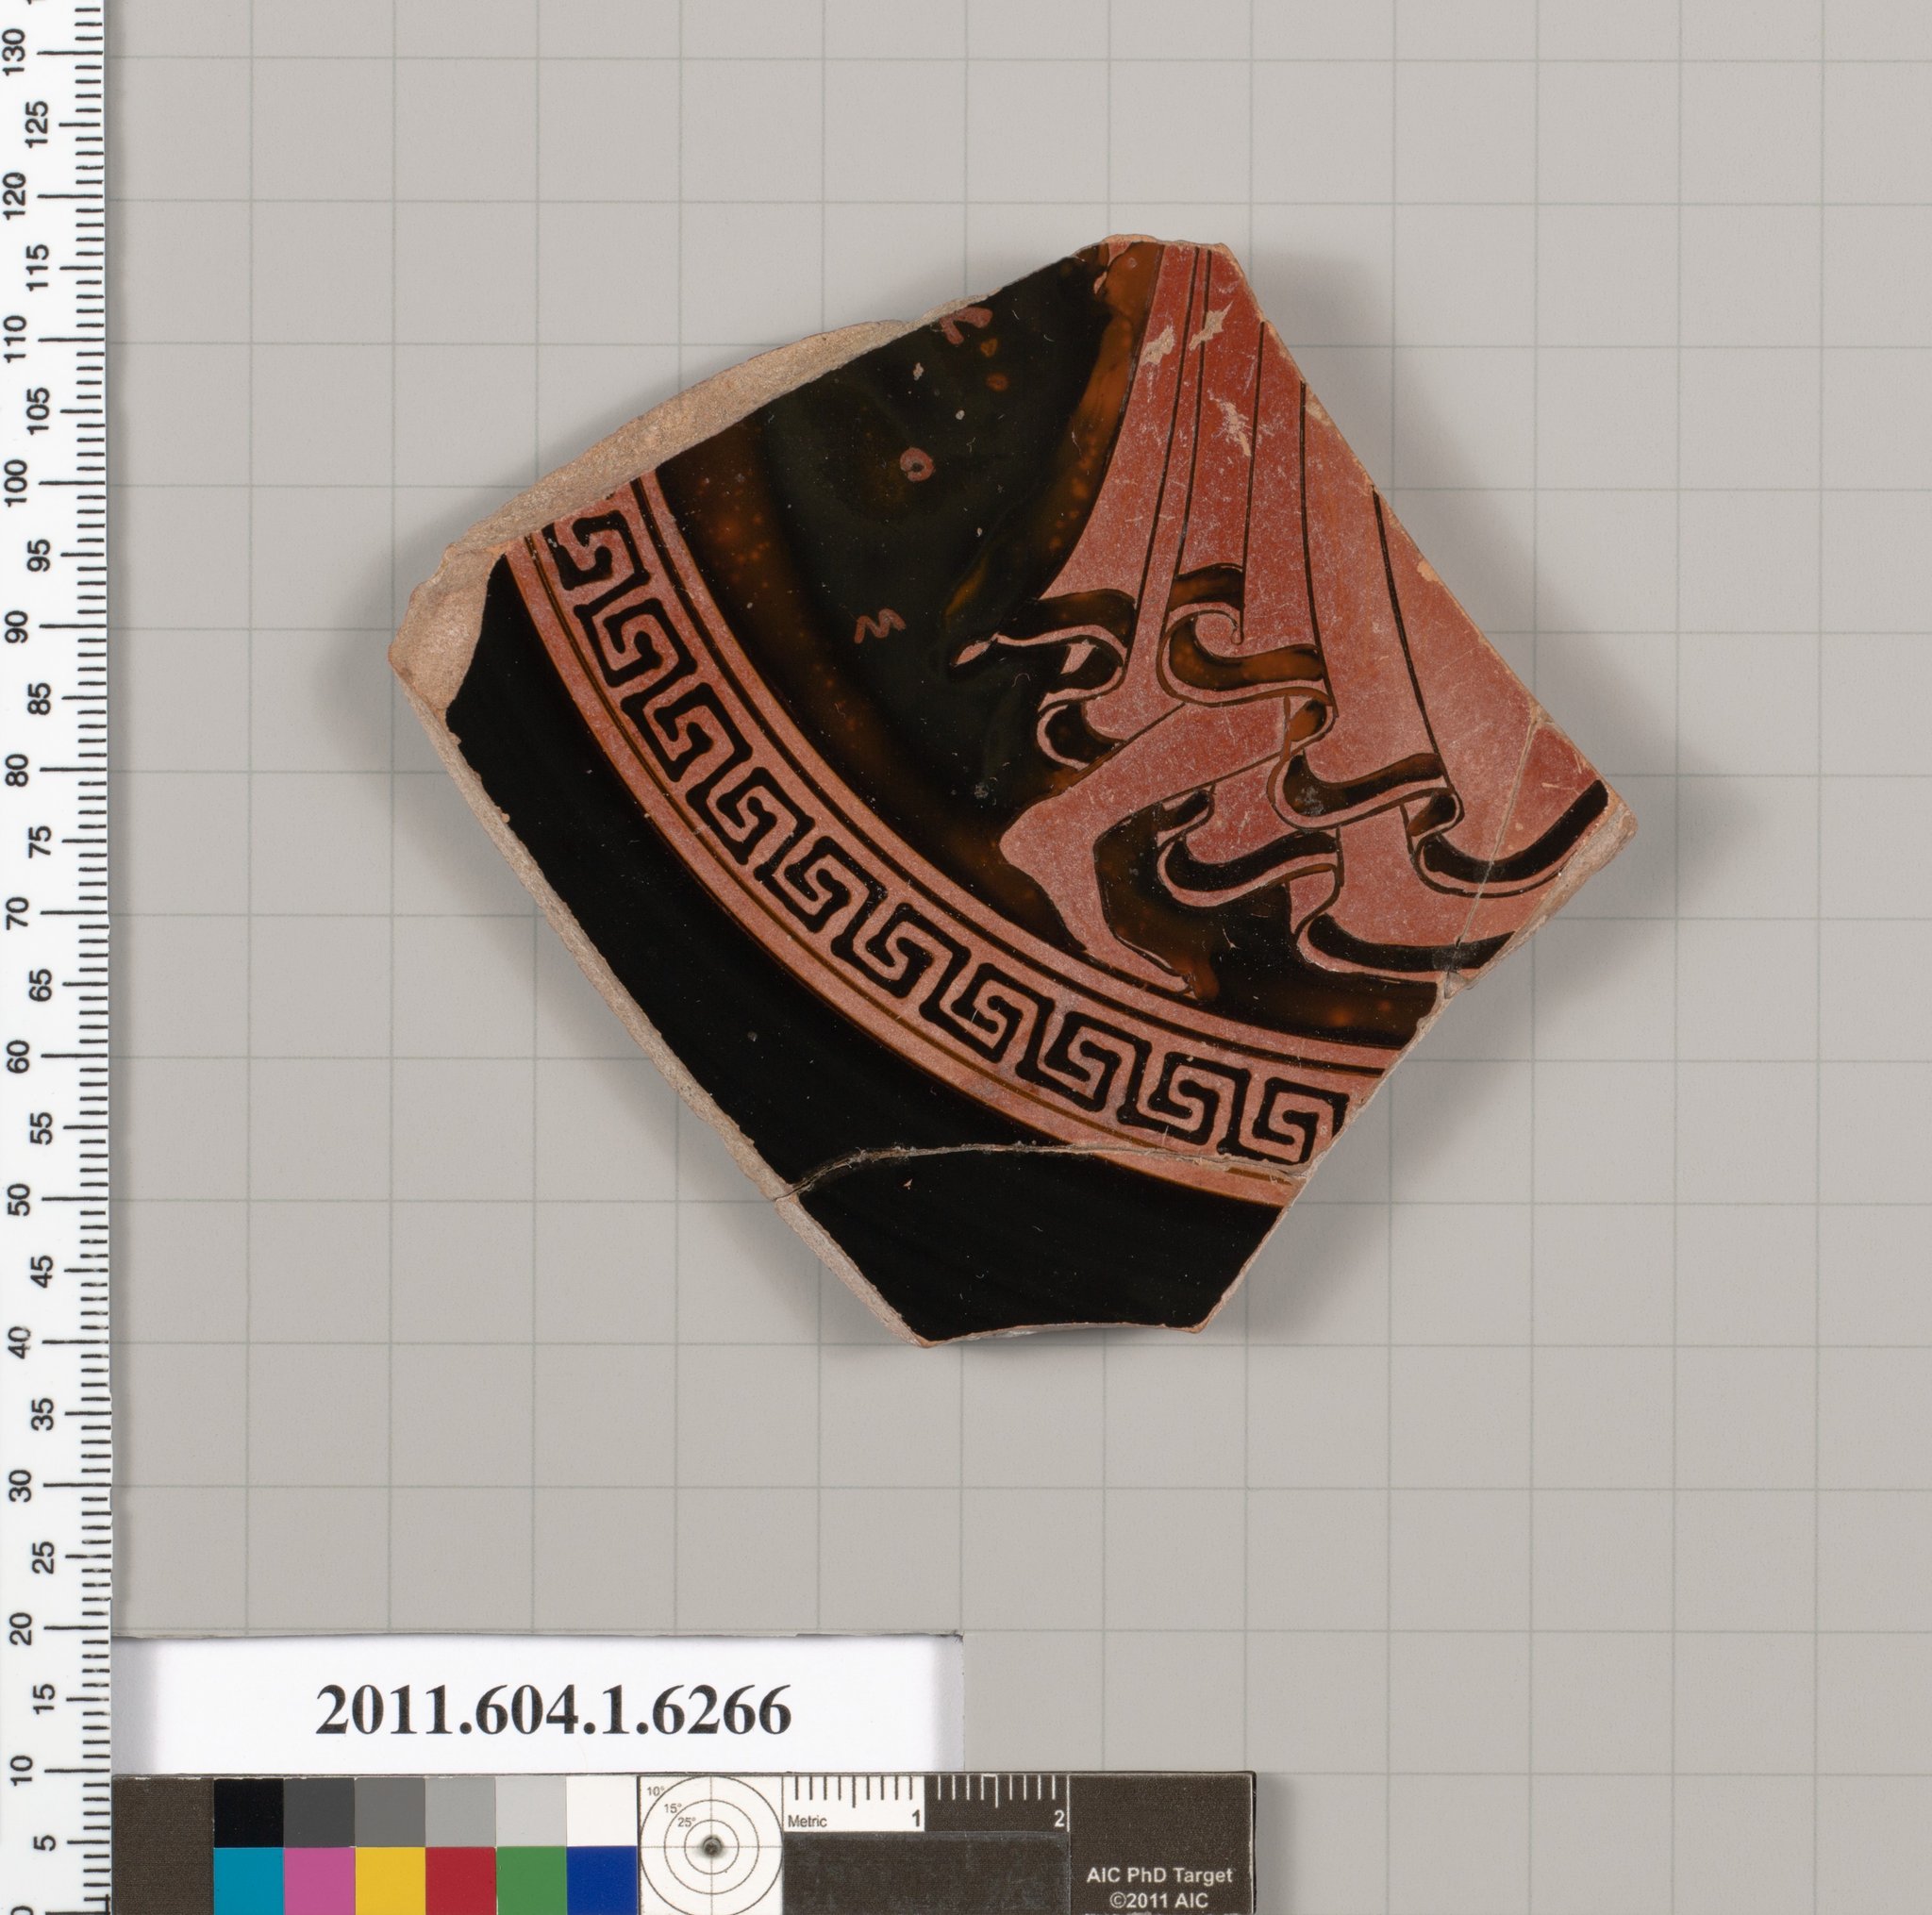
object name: kylix fragment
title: Terracotta fragment of a kylix (drinking cup)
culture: greek, attic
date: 500-480 BCE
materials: terracotta